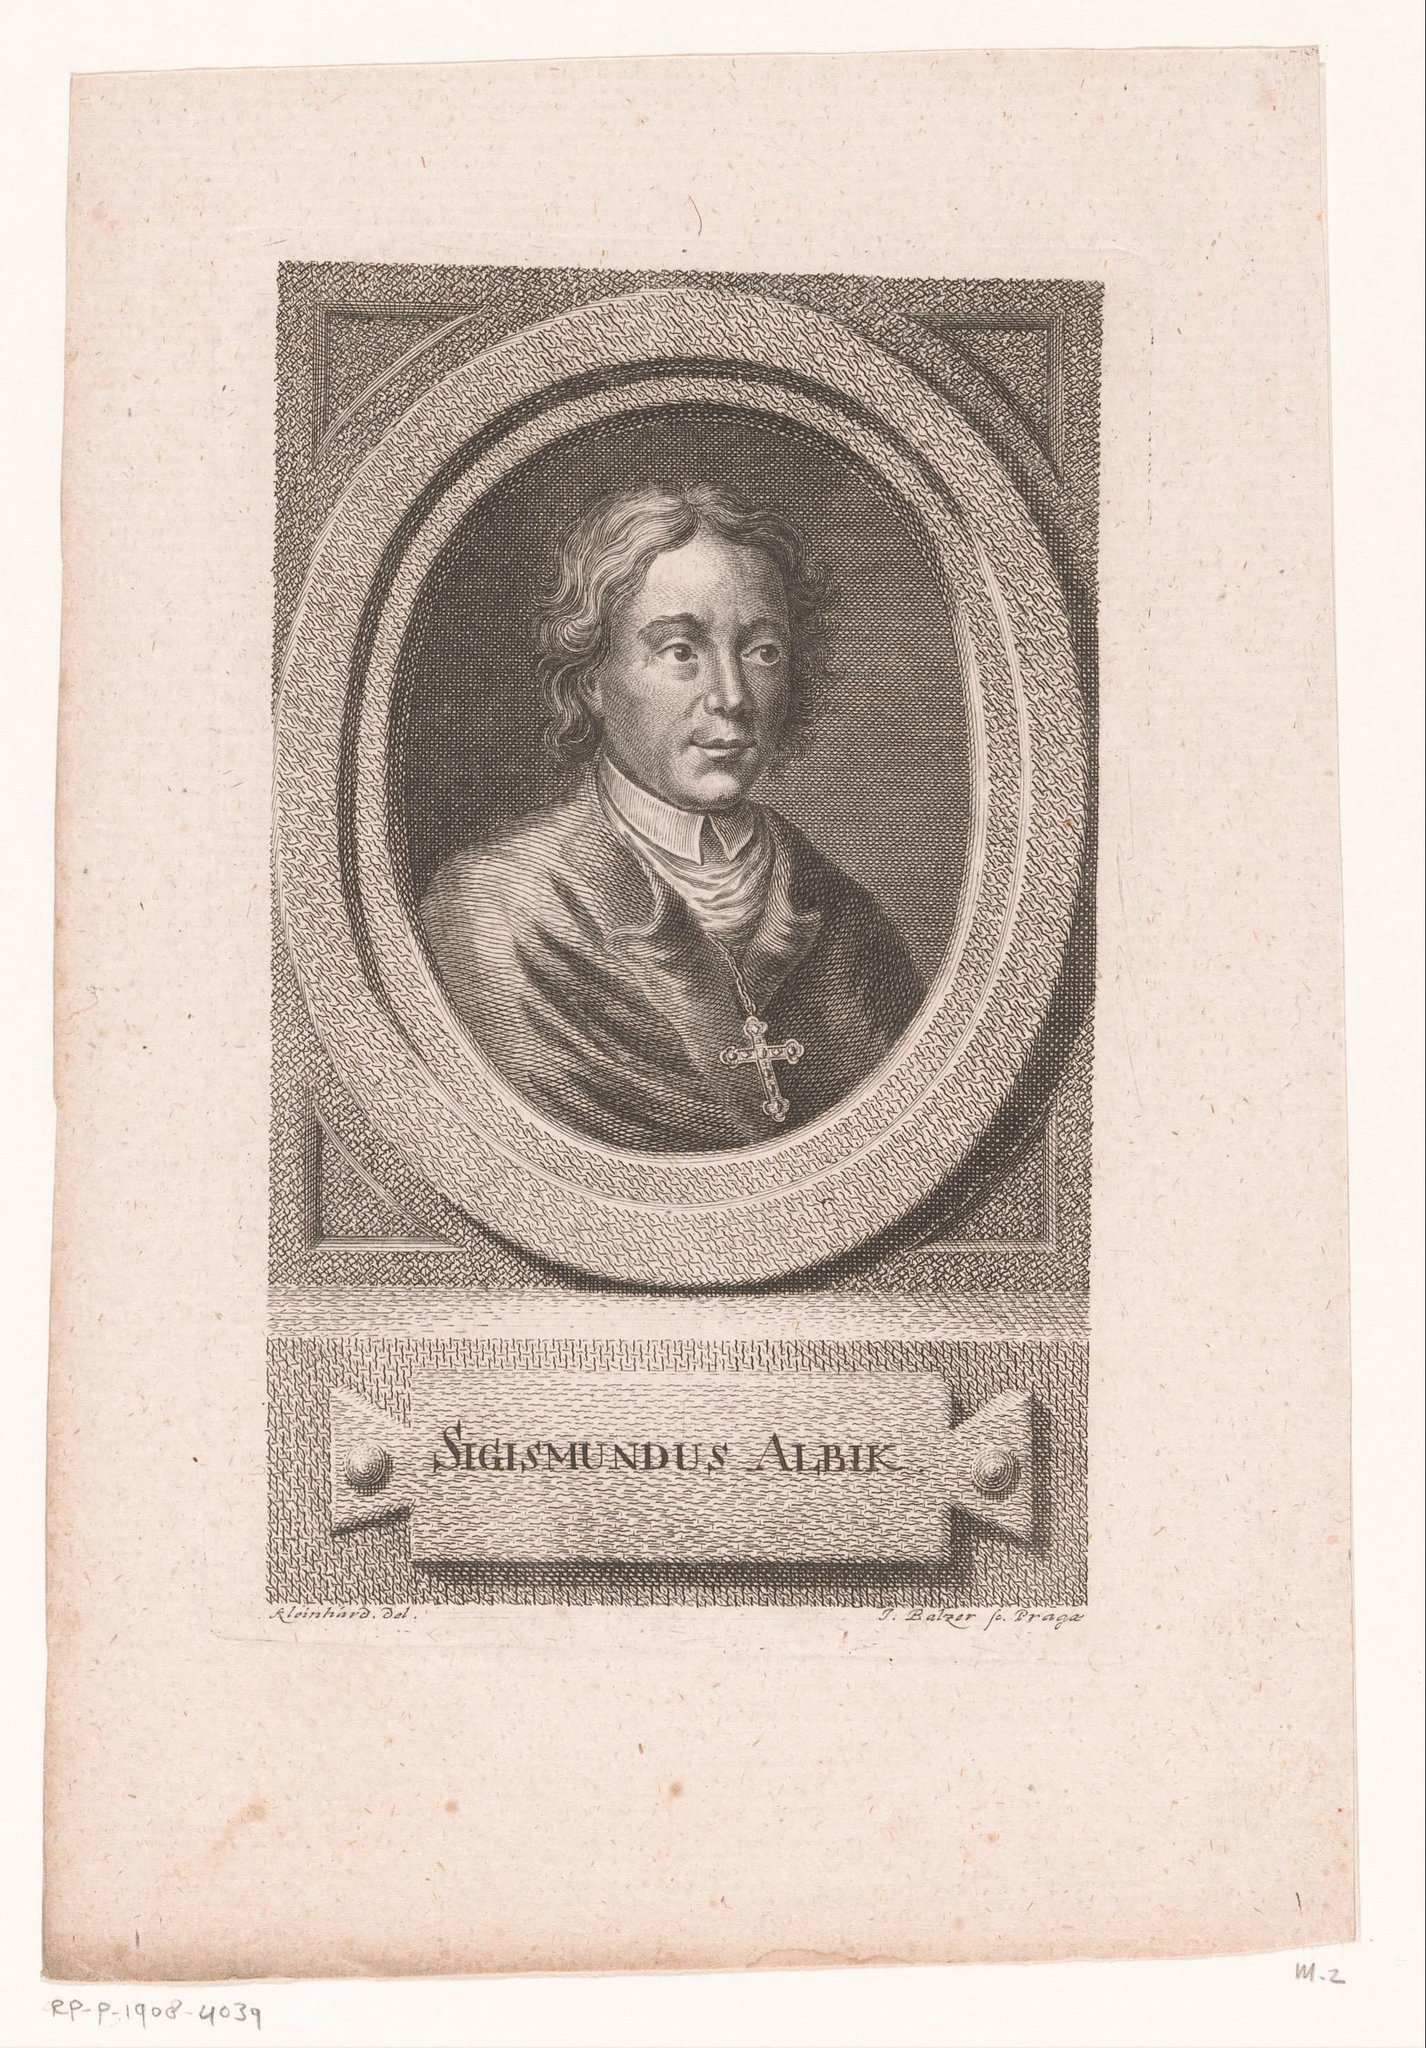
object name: print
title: Portret van Siegmund Albich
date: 1752-1799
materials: paper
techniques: engraving, etching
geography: prague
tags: historical persons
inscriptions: collector's mark: Lugt 2228